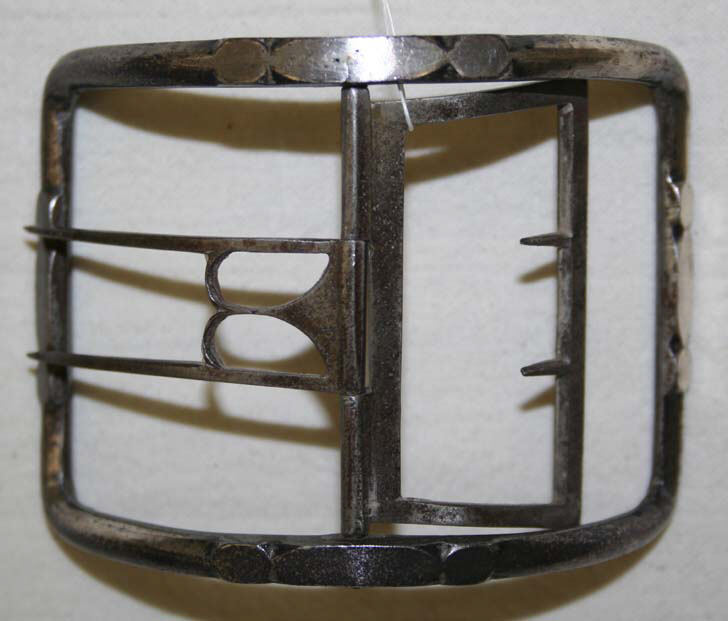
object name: shoe buckle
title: Shoe buckles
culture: british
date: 1800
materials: metal